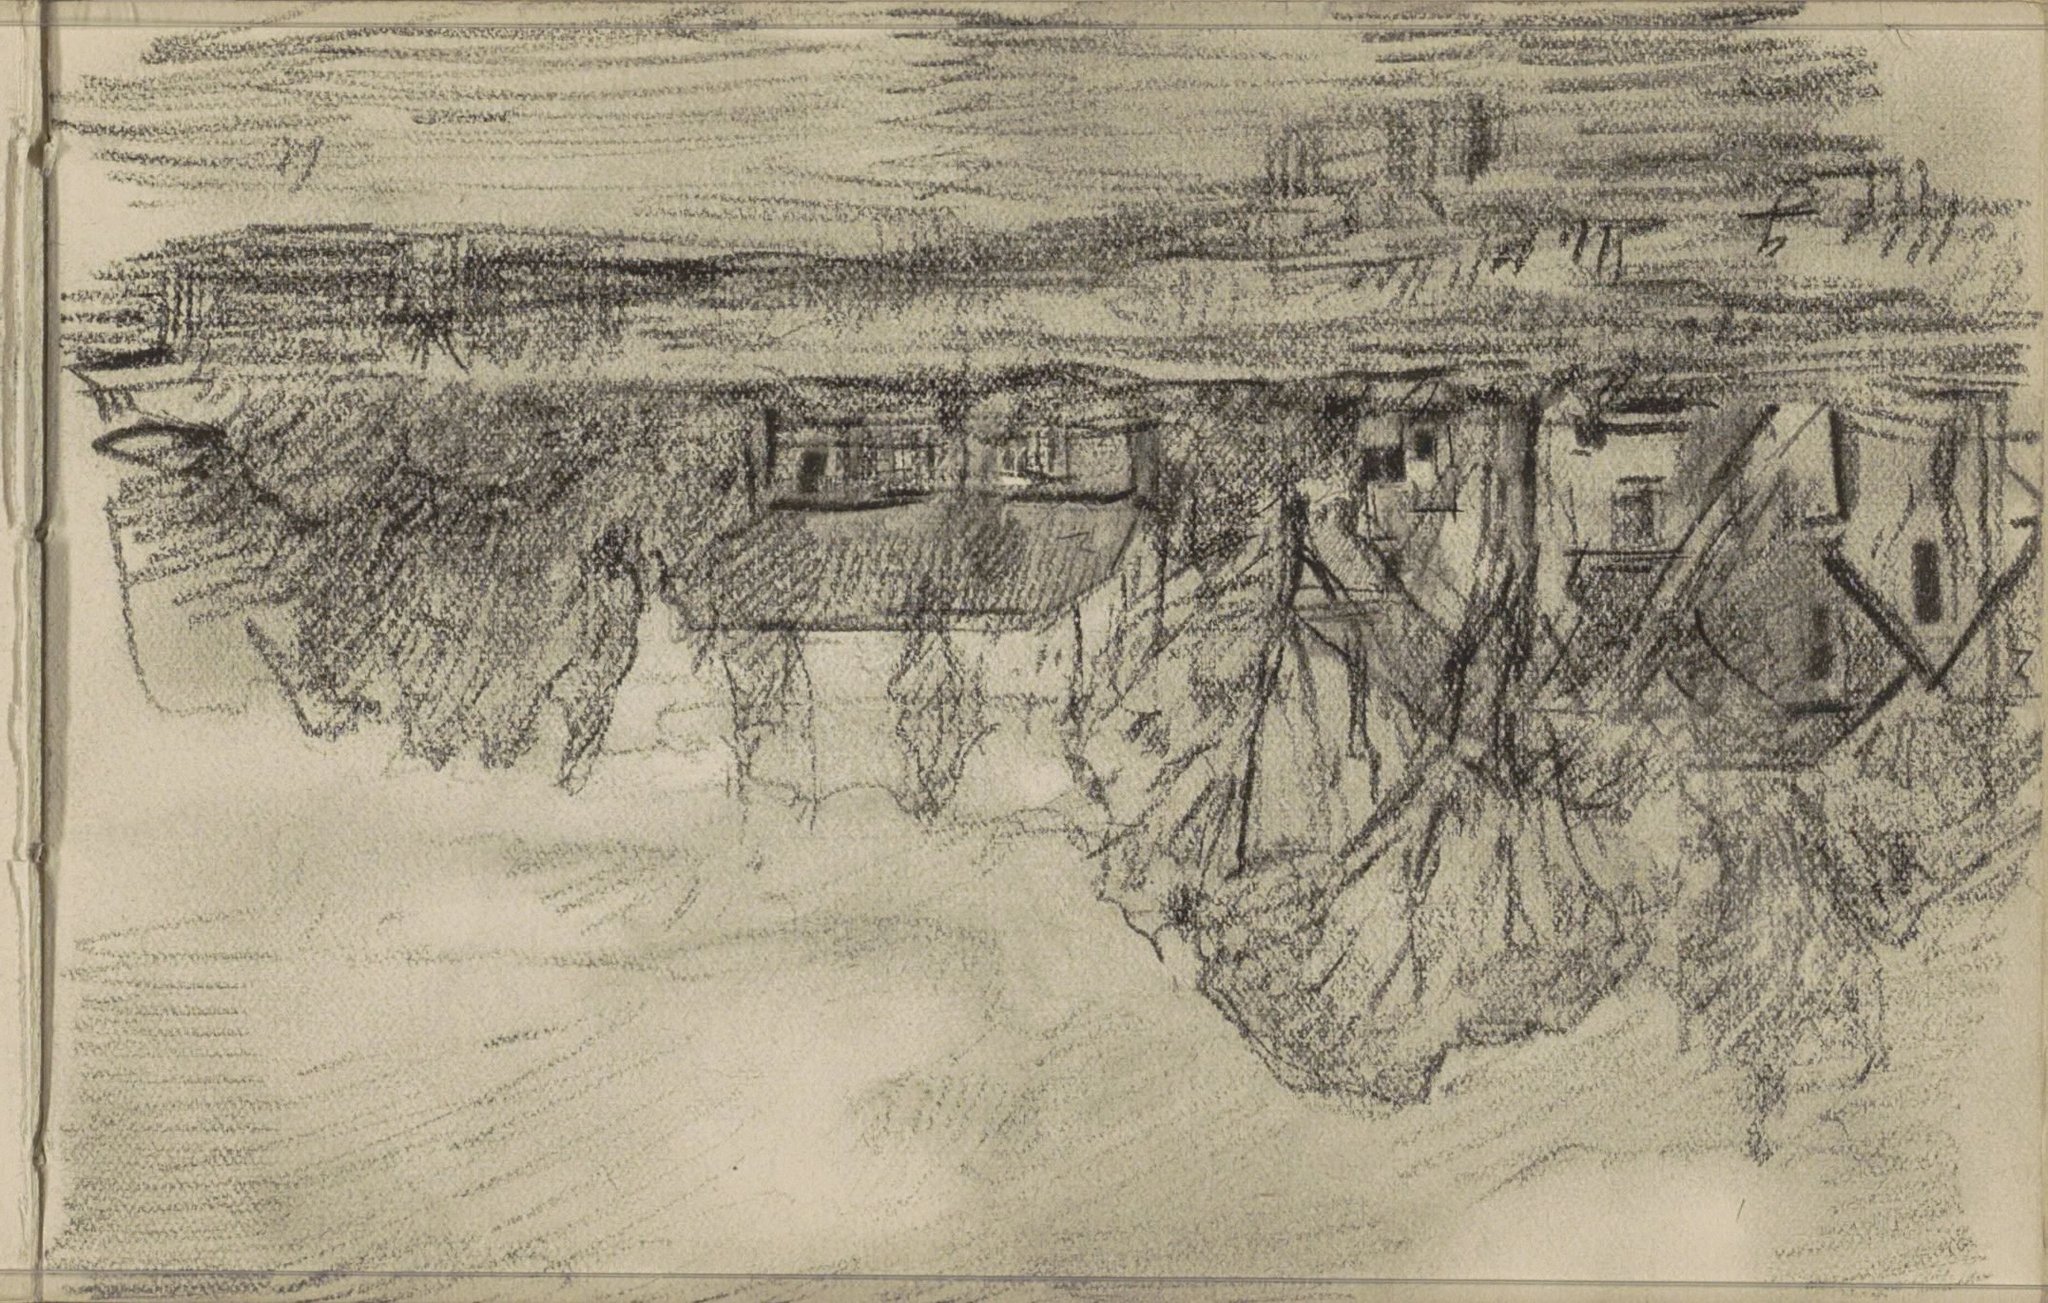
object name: sketchbook leaf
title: Gebouwen aan het water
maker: johan antonie de jonge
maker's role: draughtsman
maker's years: 1864-1927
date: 1909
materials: chalk, paper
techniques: stumping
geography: south holland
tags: rural housing, e.g. country-house, villa, cottage, water course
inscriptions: kleurnotitie, handgeschreven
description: Gebouwen aan het water. Blad 22 recto uit een schetsboek met 31 bladen.